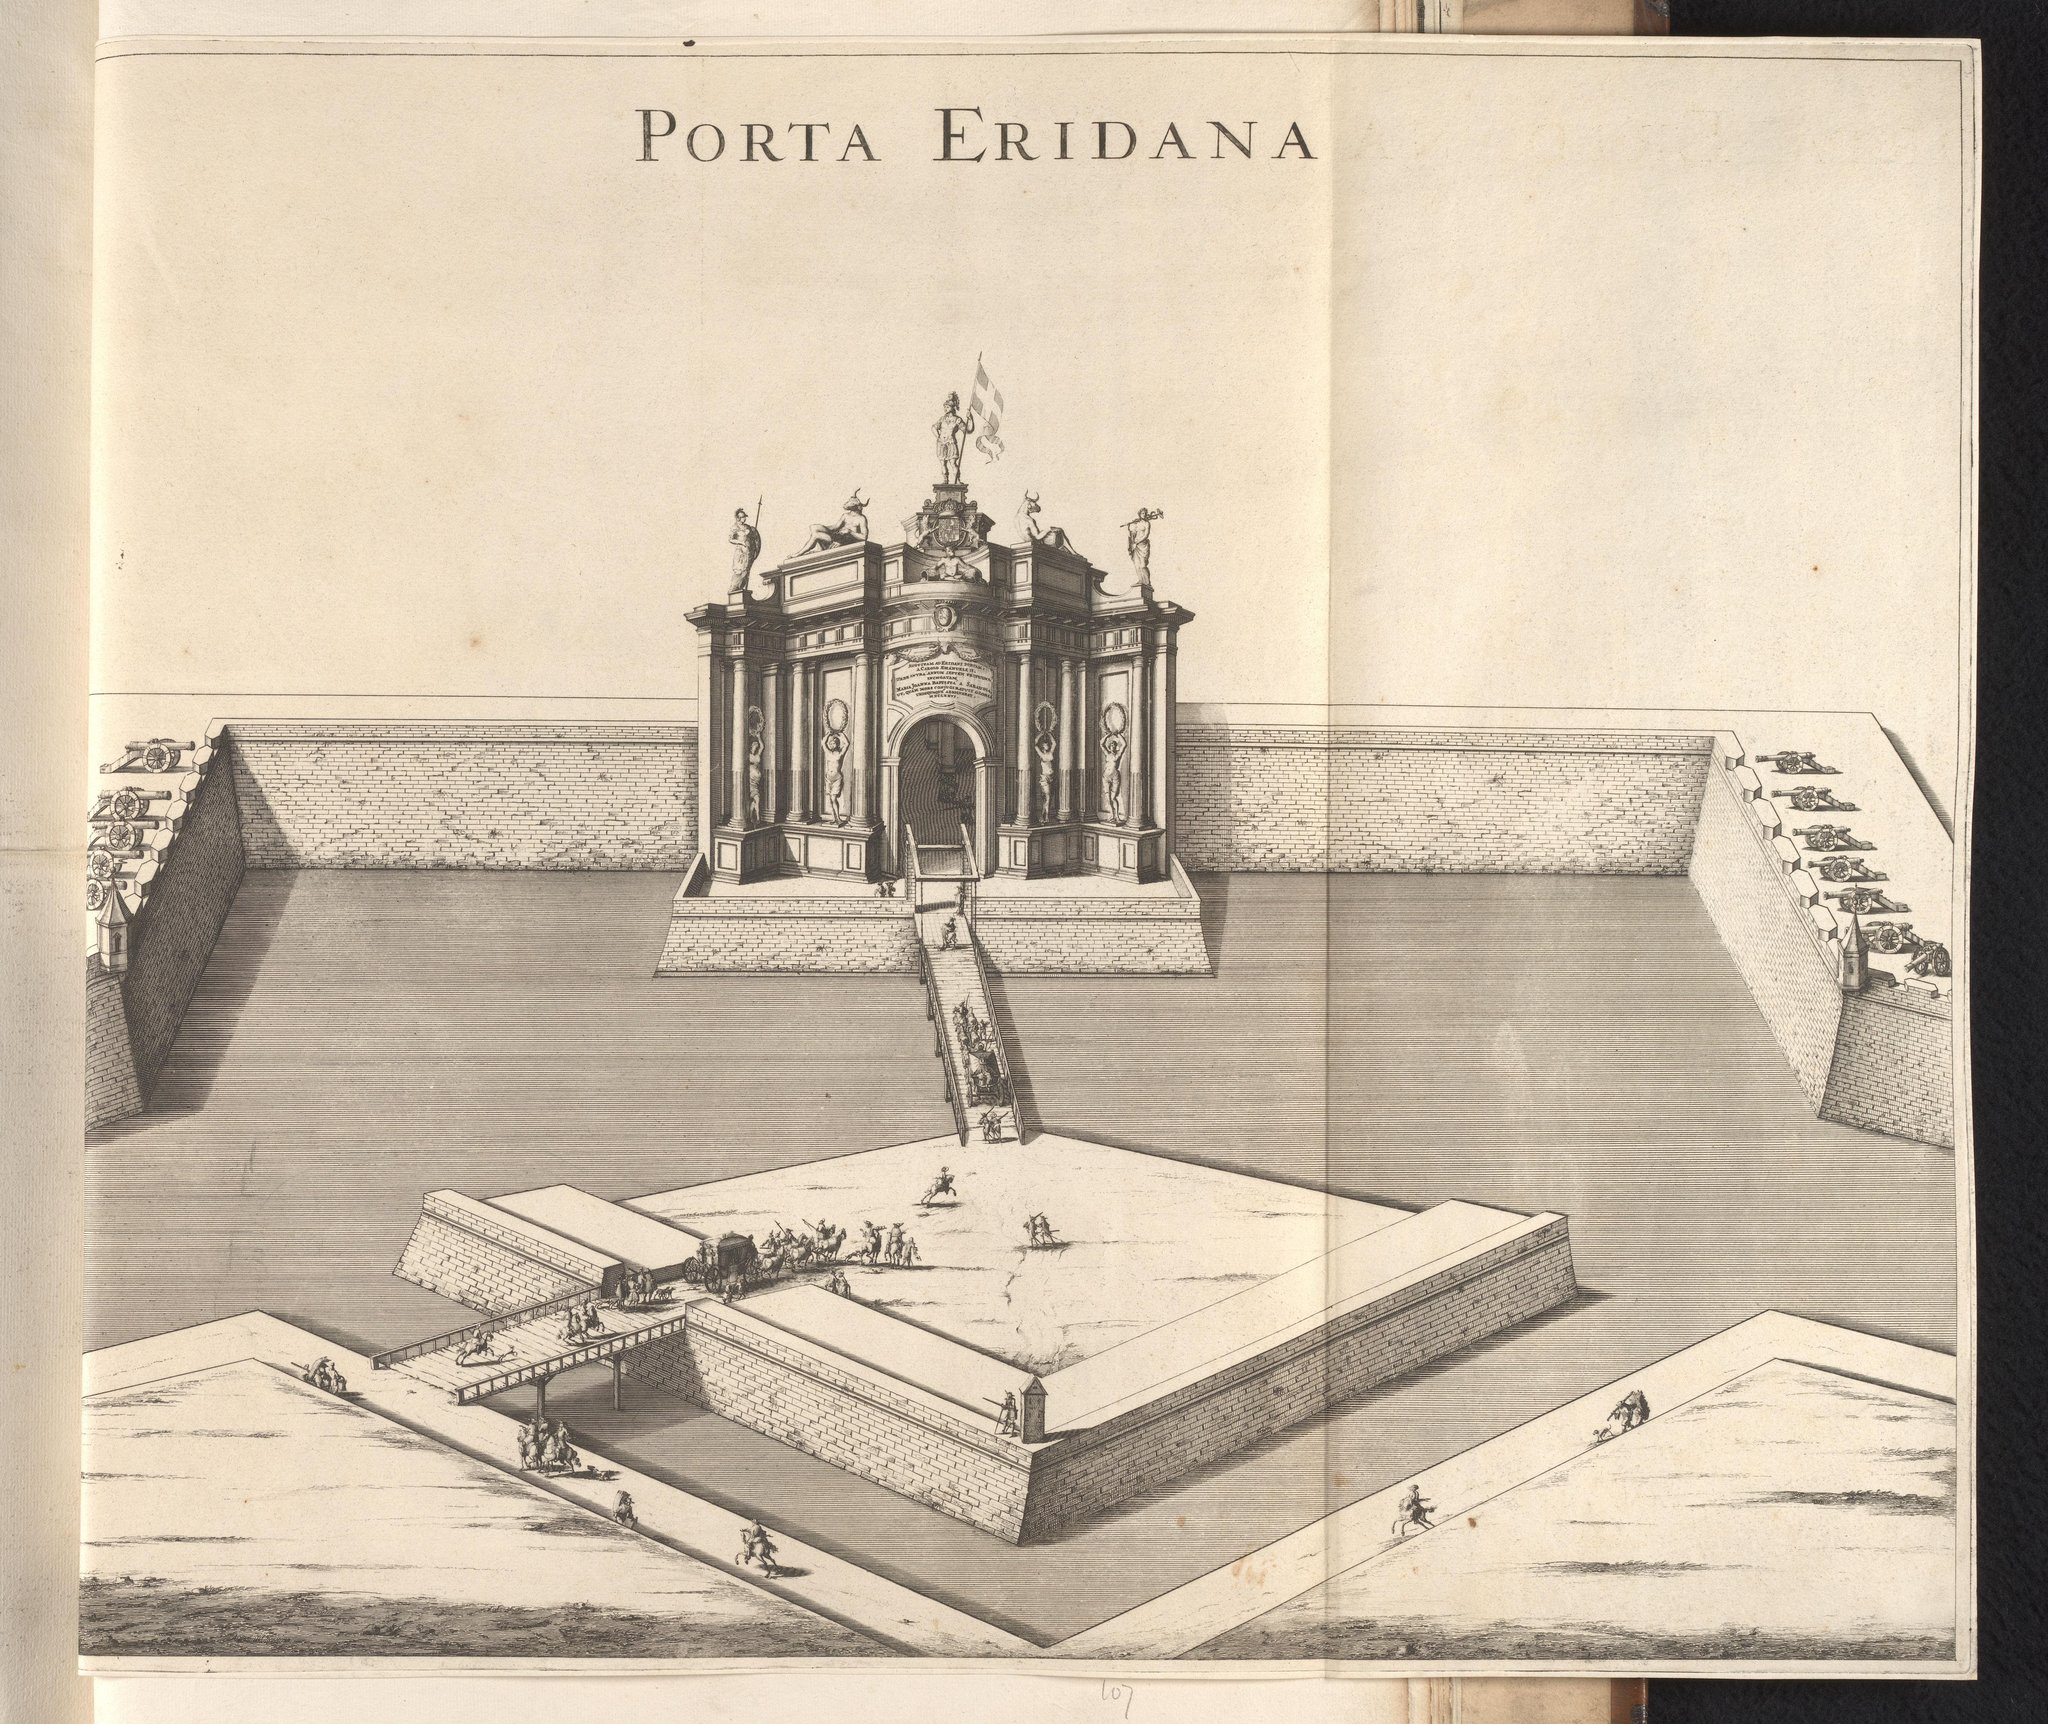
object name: print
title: Porta di Po te Turijn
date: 1682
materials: paper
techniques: etching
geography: turin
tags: representation of real building (either existing or having existed), city-gate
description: Deze prent maakt deel uit van een reeks met bouwwerken binnen het domein van de Savoie-familie in de late 17e eeuw.